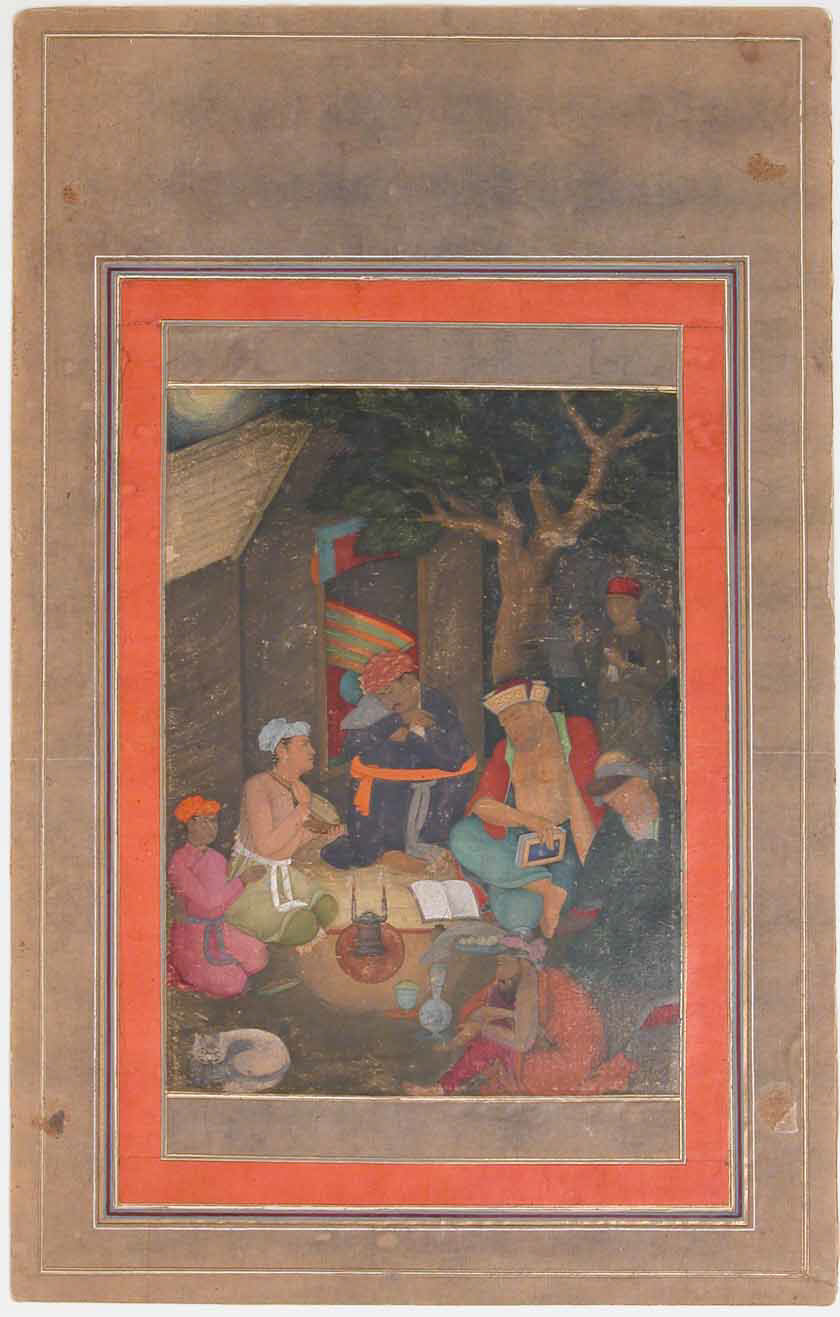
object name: illustrated album leaf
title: "Night Scene: Group Listening to Music", Folio from the Davis Album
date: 1667-1700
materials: gold, ink, paper, watercolor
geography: india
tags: men,music